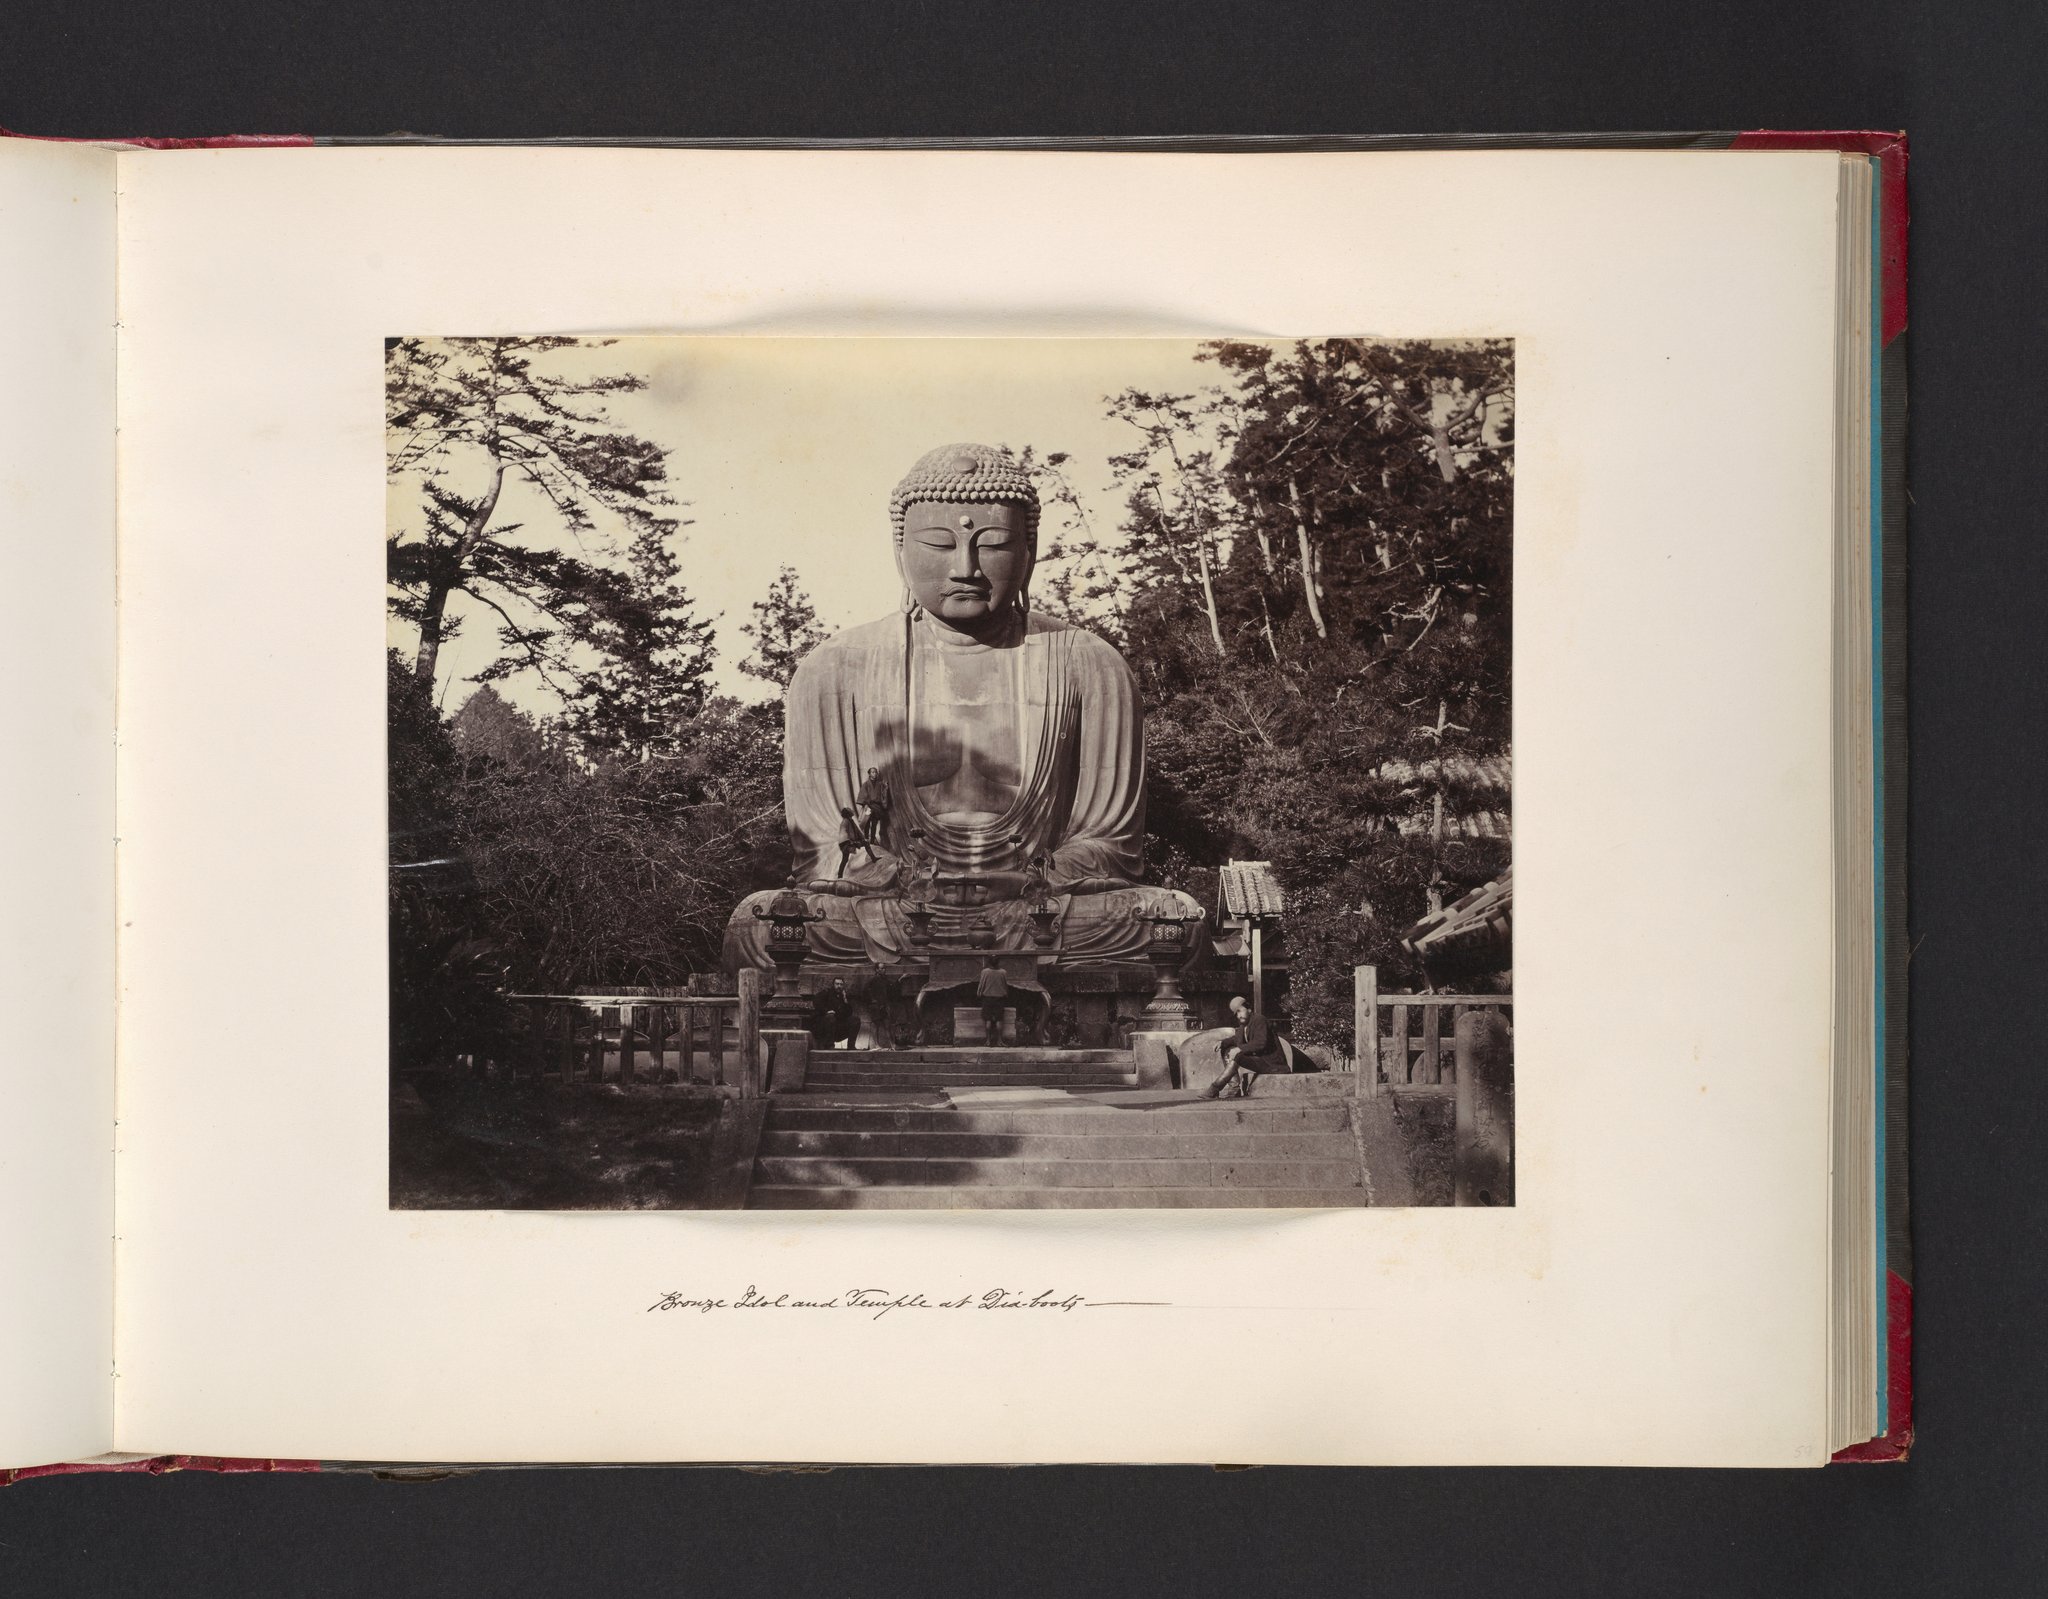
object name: photograph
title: Bronze Idol and Temple at Dia-boots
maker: john thomson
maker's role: artist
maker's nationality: british, scottish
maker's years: 1837-1921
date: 1865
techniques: albumen silver print, glass negative